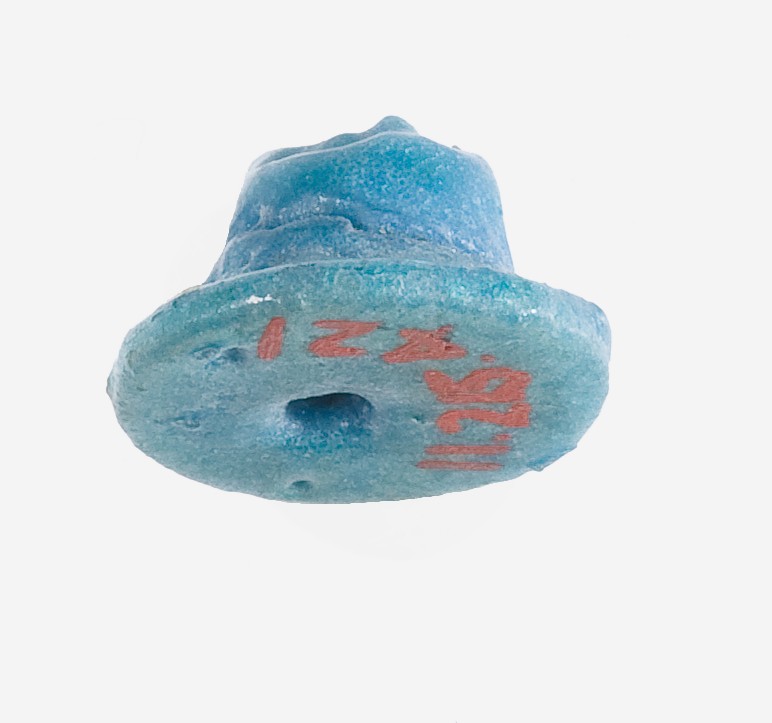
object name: pendant, umbel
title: Umbel Pendant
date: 1390-1352 BCE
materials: faience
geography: egypt